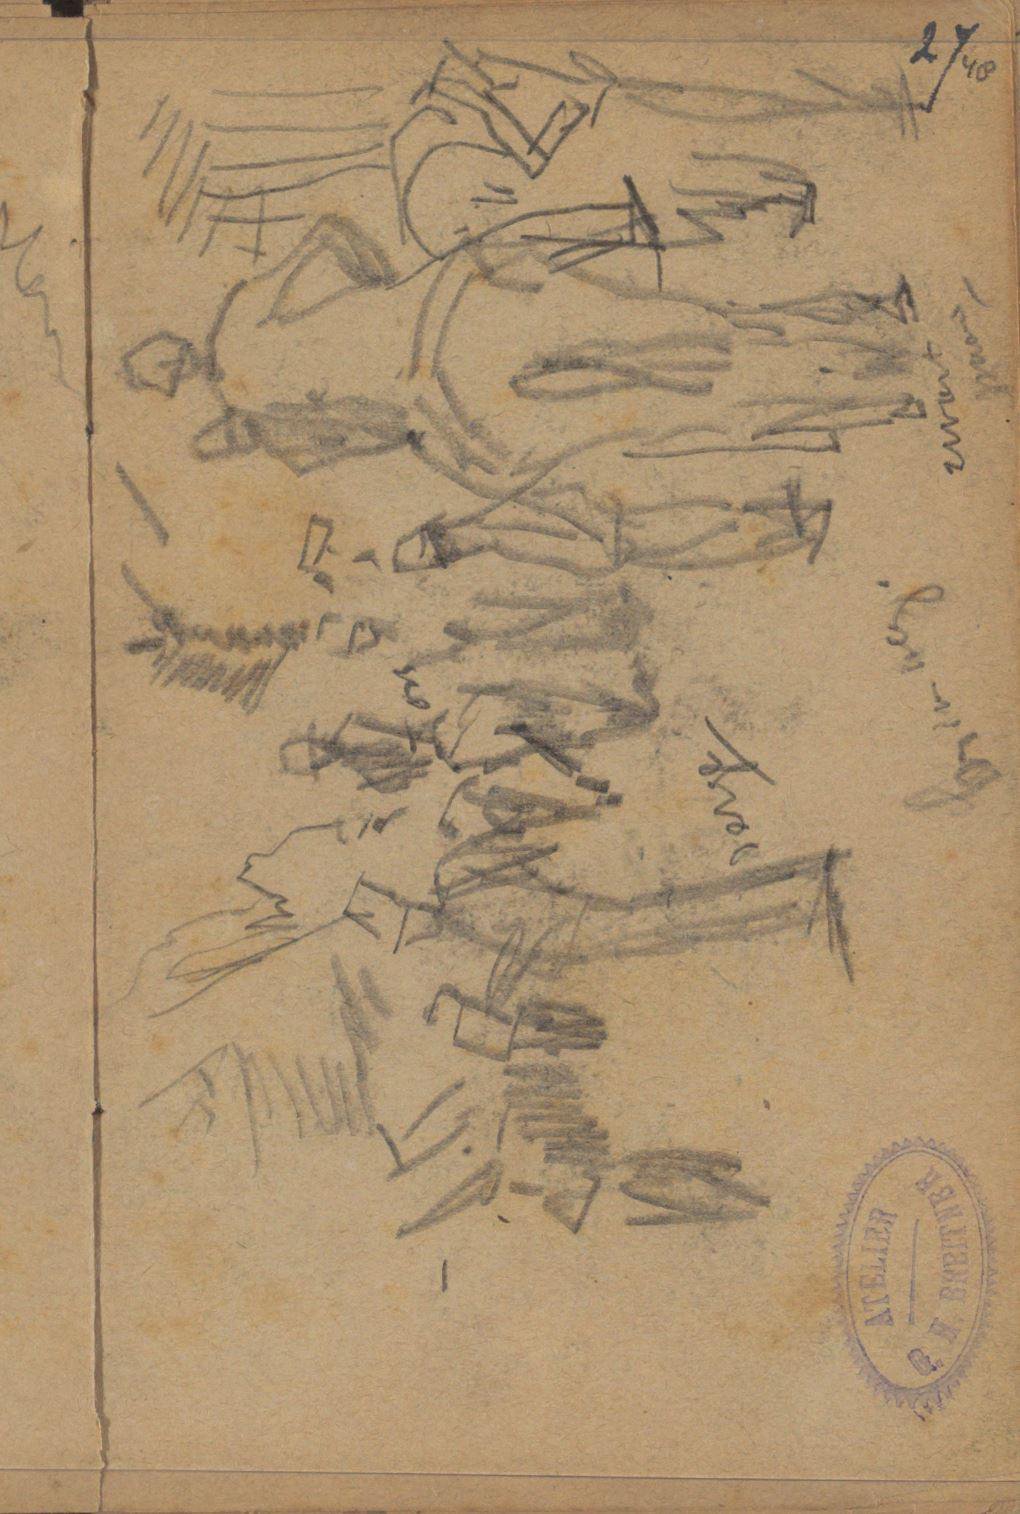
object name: sketchbook leaf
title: Infanteristen op de Bremweg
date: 1887-1891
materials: paper, pencil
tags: division of armed forces (+ infantry), horse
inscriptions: :, workshop stamp: Lugt 291d, annotation: ‘Bremweg[?]’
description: Sommigen te paard. Pagina 48 uit een schetsboek met 83 bladen.